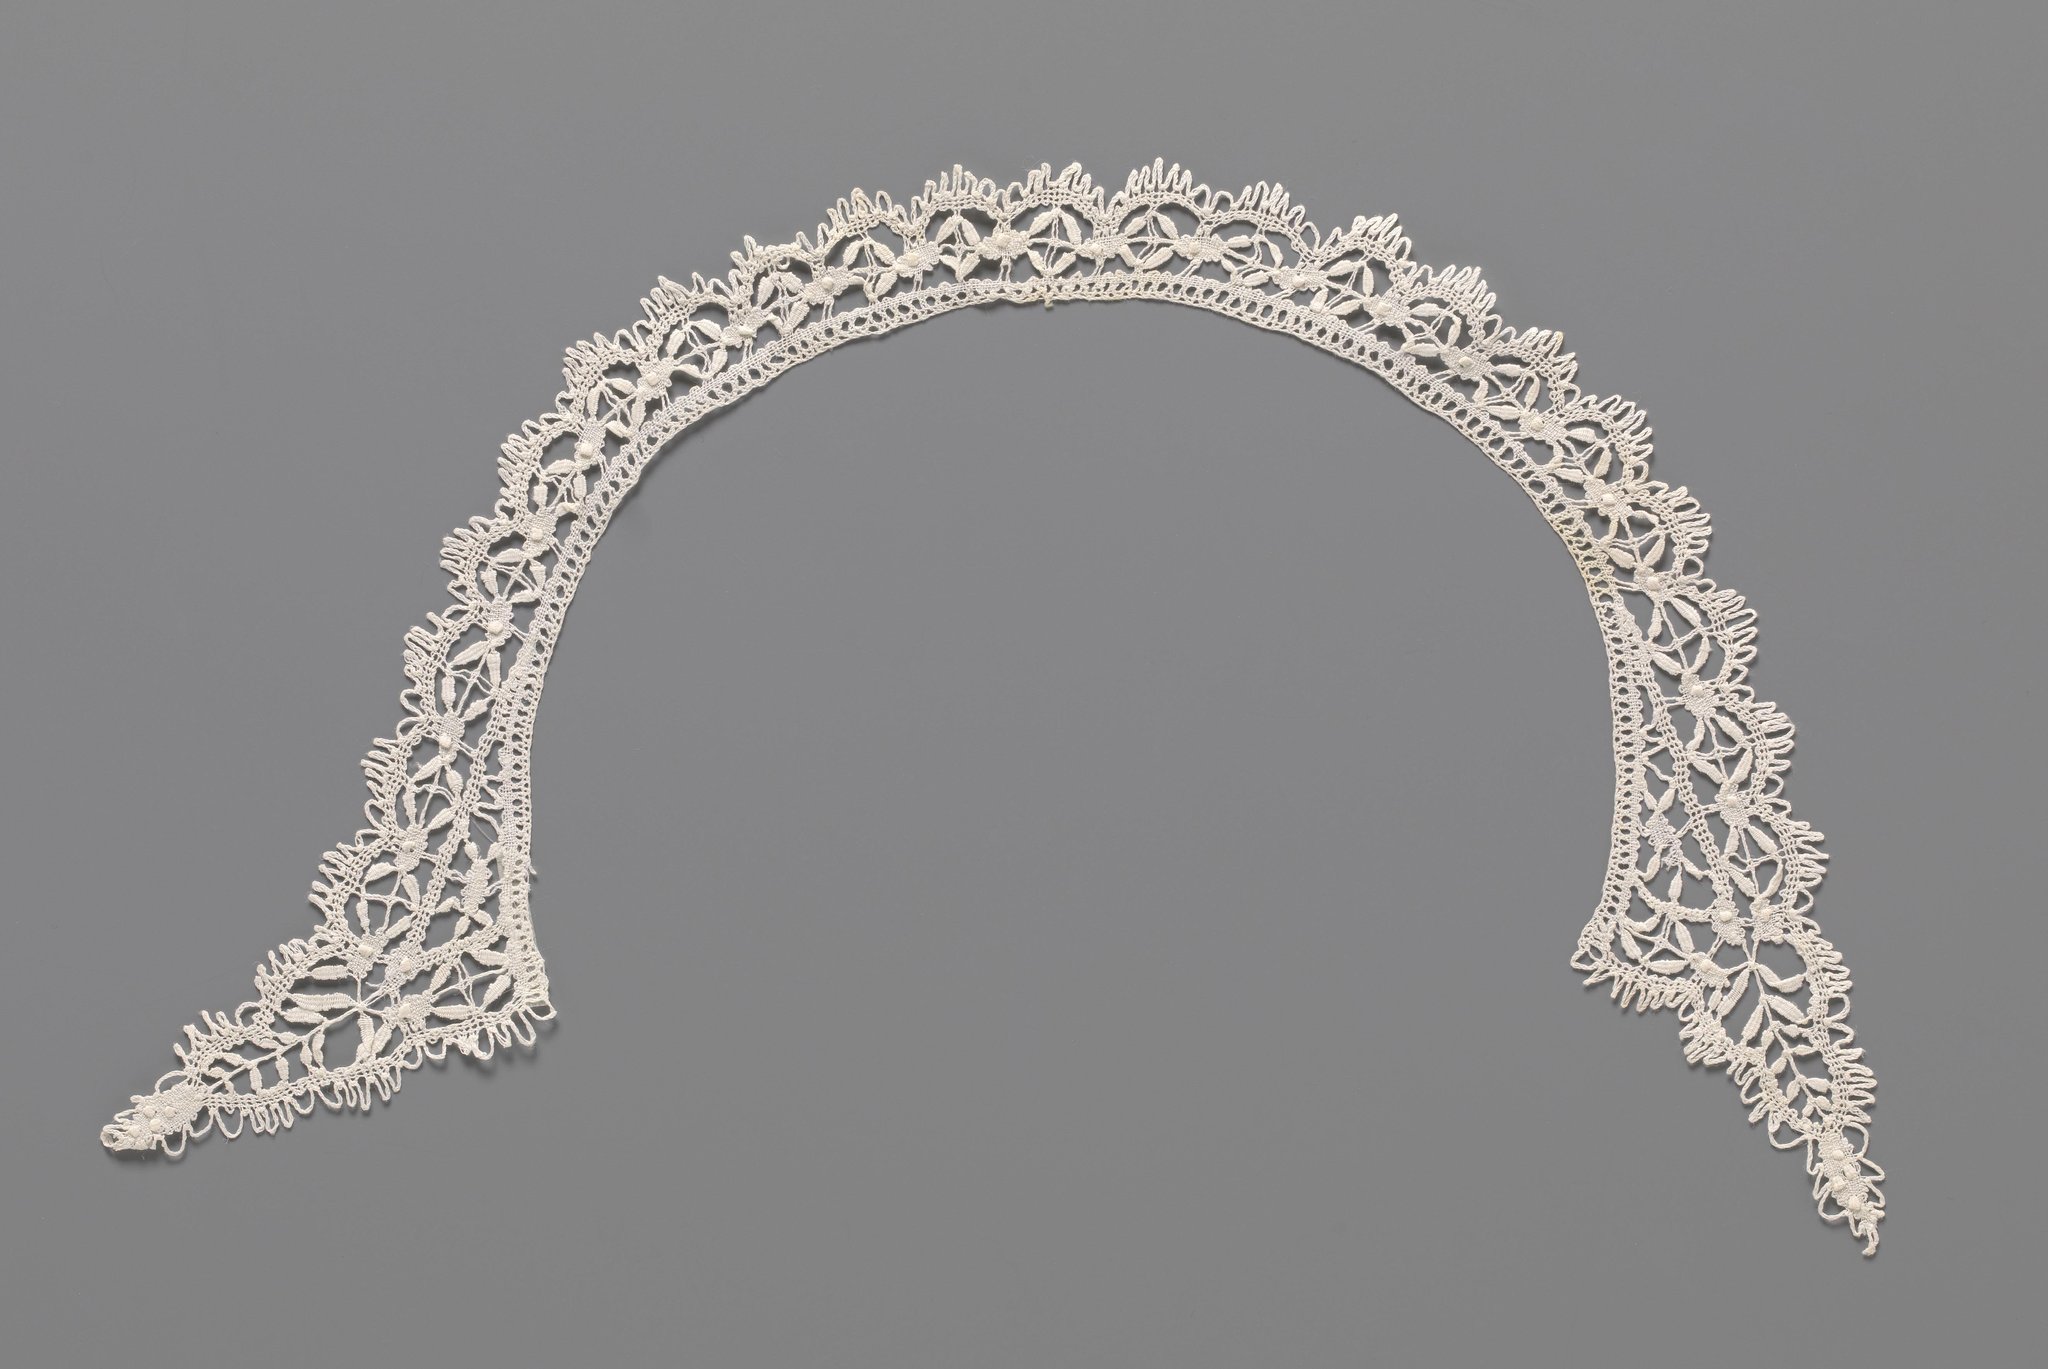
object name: collar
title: Kraag van kloskant met geometrisch patroon van dubbele zigzag met boogjesrand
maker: Anonymous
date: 1900-1930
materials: cotton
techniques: lace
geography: le puy-en-velay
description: Kraag van naturelkleurig kloskant: Cluny-kant. Liggend rond model met een smal midden en lange punten aan de einden. De kraag is niet symmetrisch omdat één van de punten een knik maakt naar buiten en de andere punt niet. Het patroon heeft een dubbele zigzag-lijn met ovalen op de knooppunten, waar doorheen lengte- en dwarslijnen. De motieven zijn geklost in linnenslag met versieringen in vormslag. De motieven zijn met elkaar verbonden door een vlechtengrond. Schulpenrand met vlakke gelijkvormige schulpen met heen en weer lopende lussen.